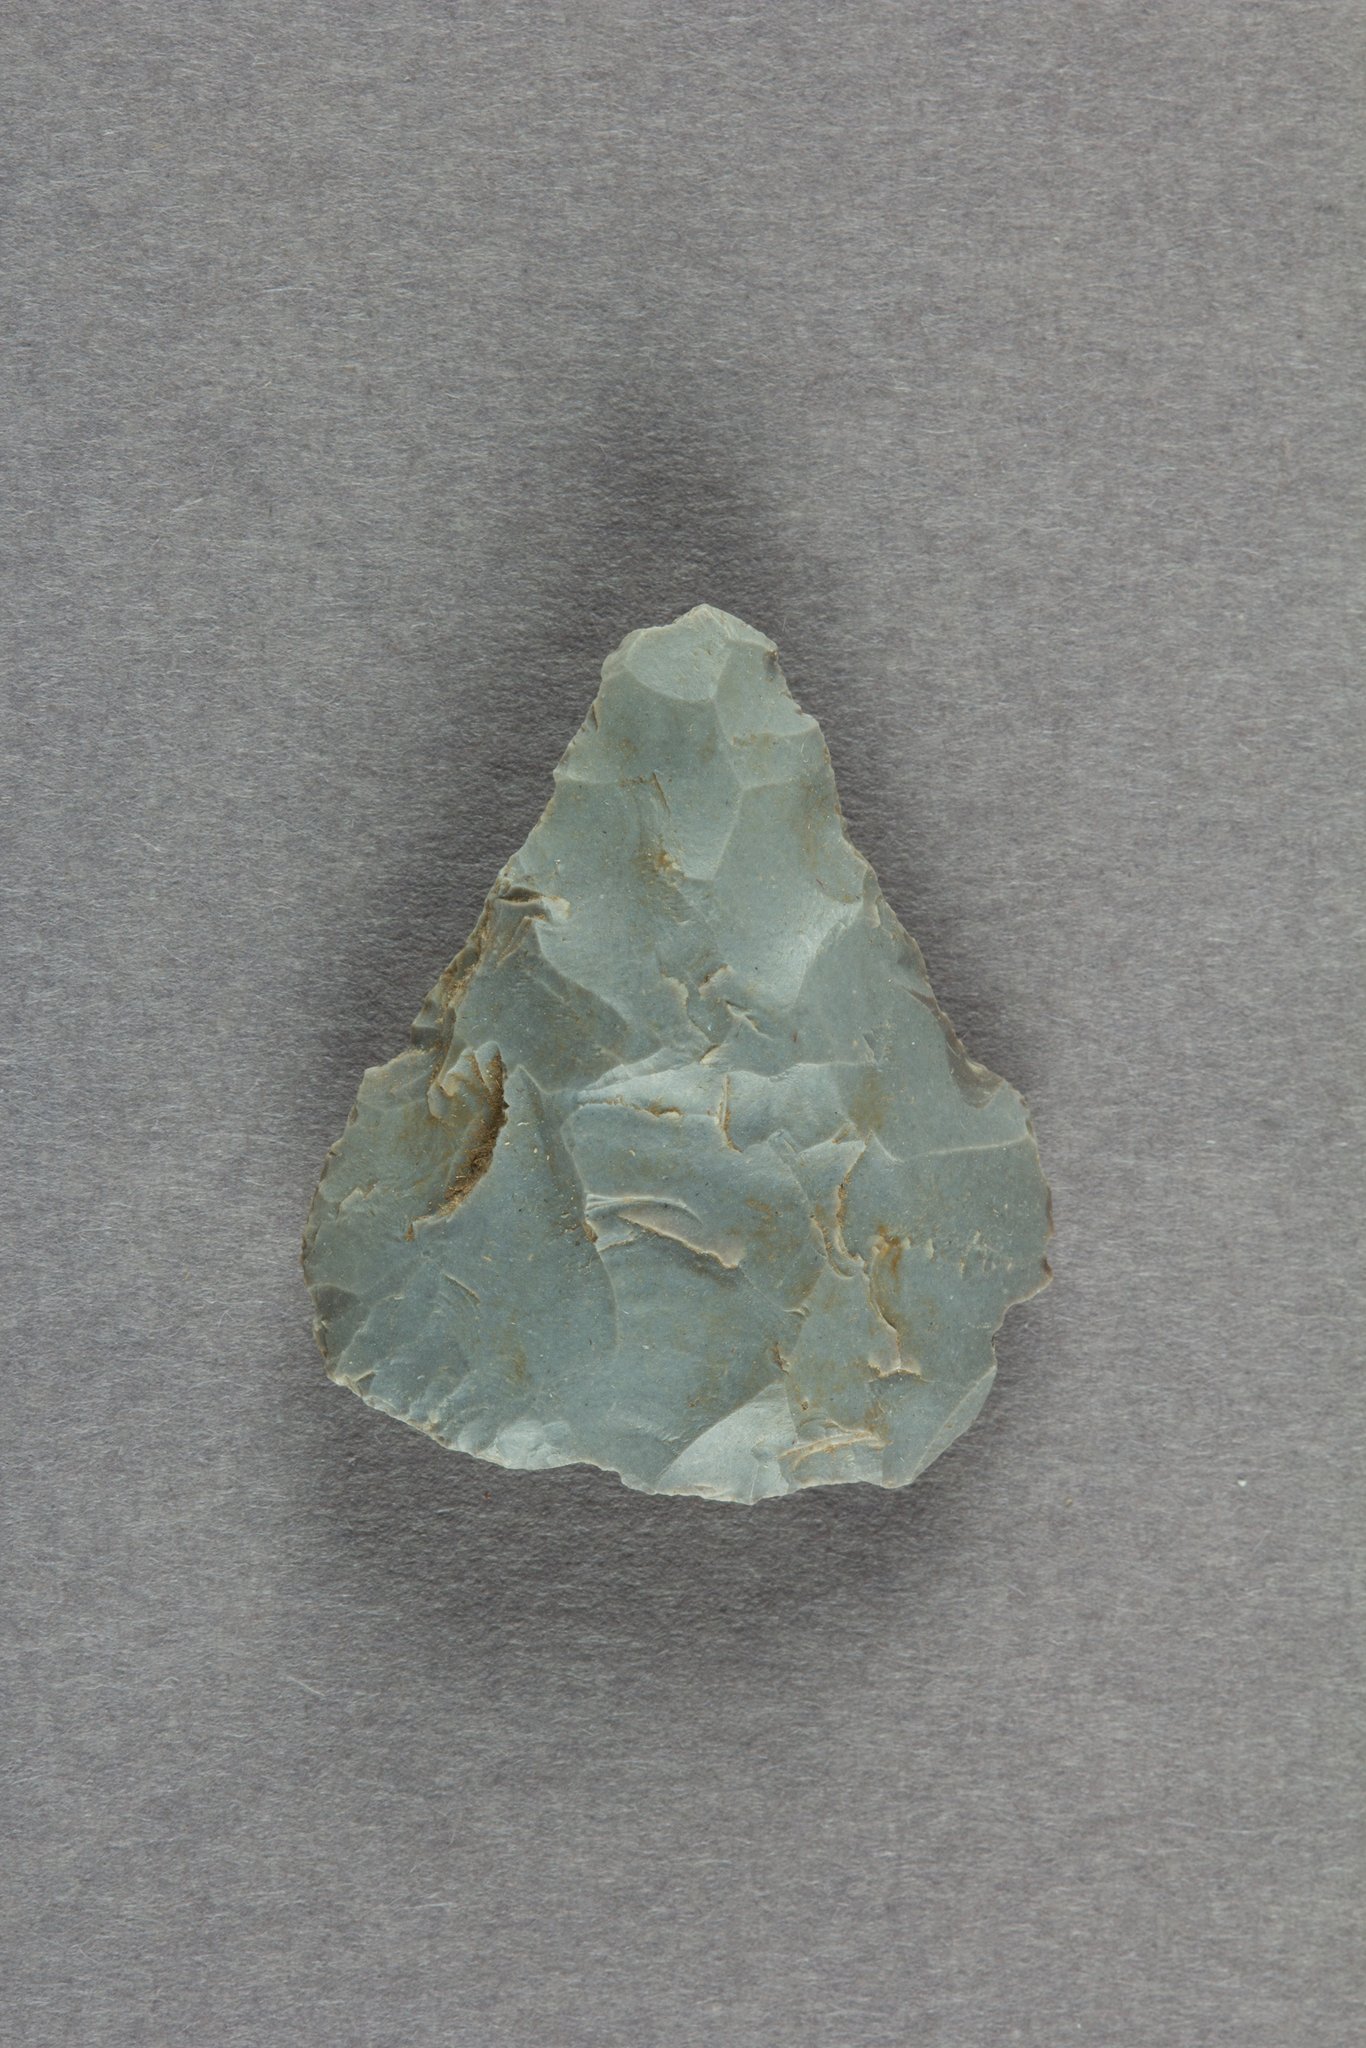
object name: arrowhead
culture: japanese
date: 1500-1000 BCE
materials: stone